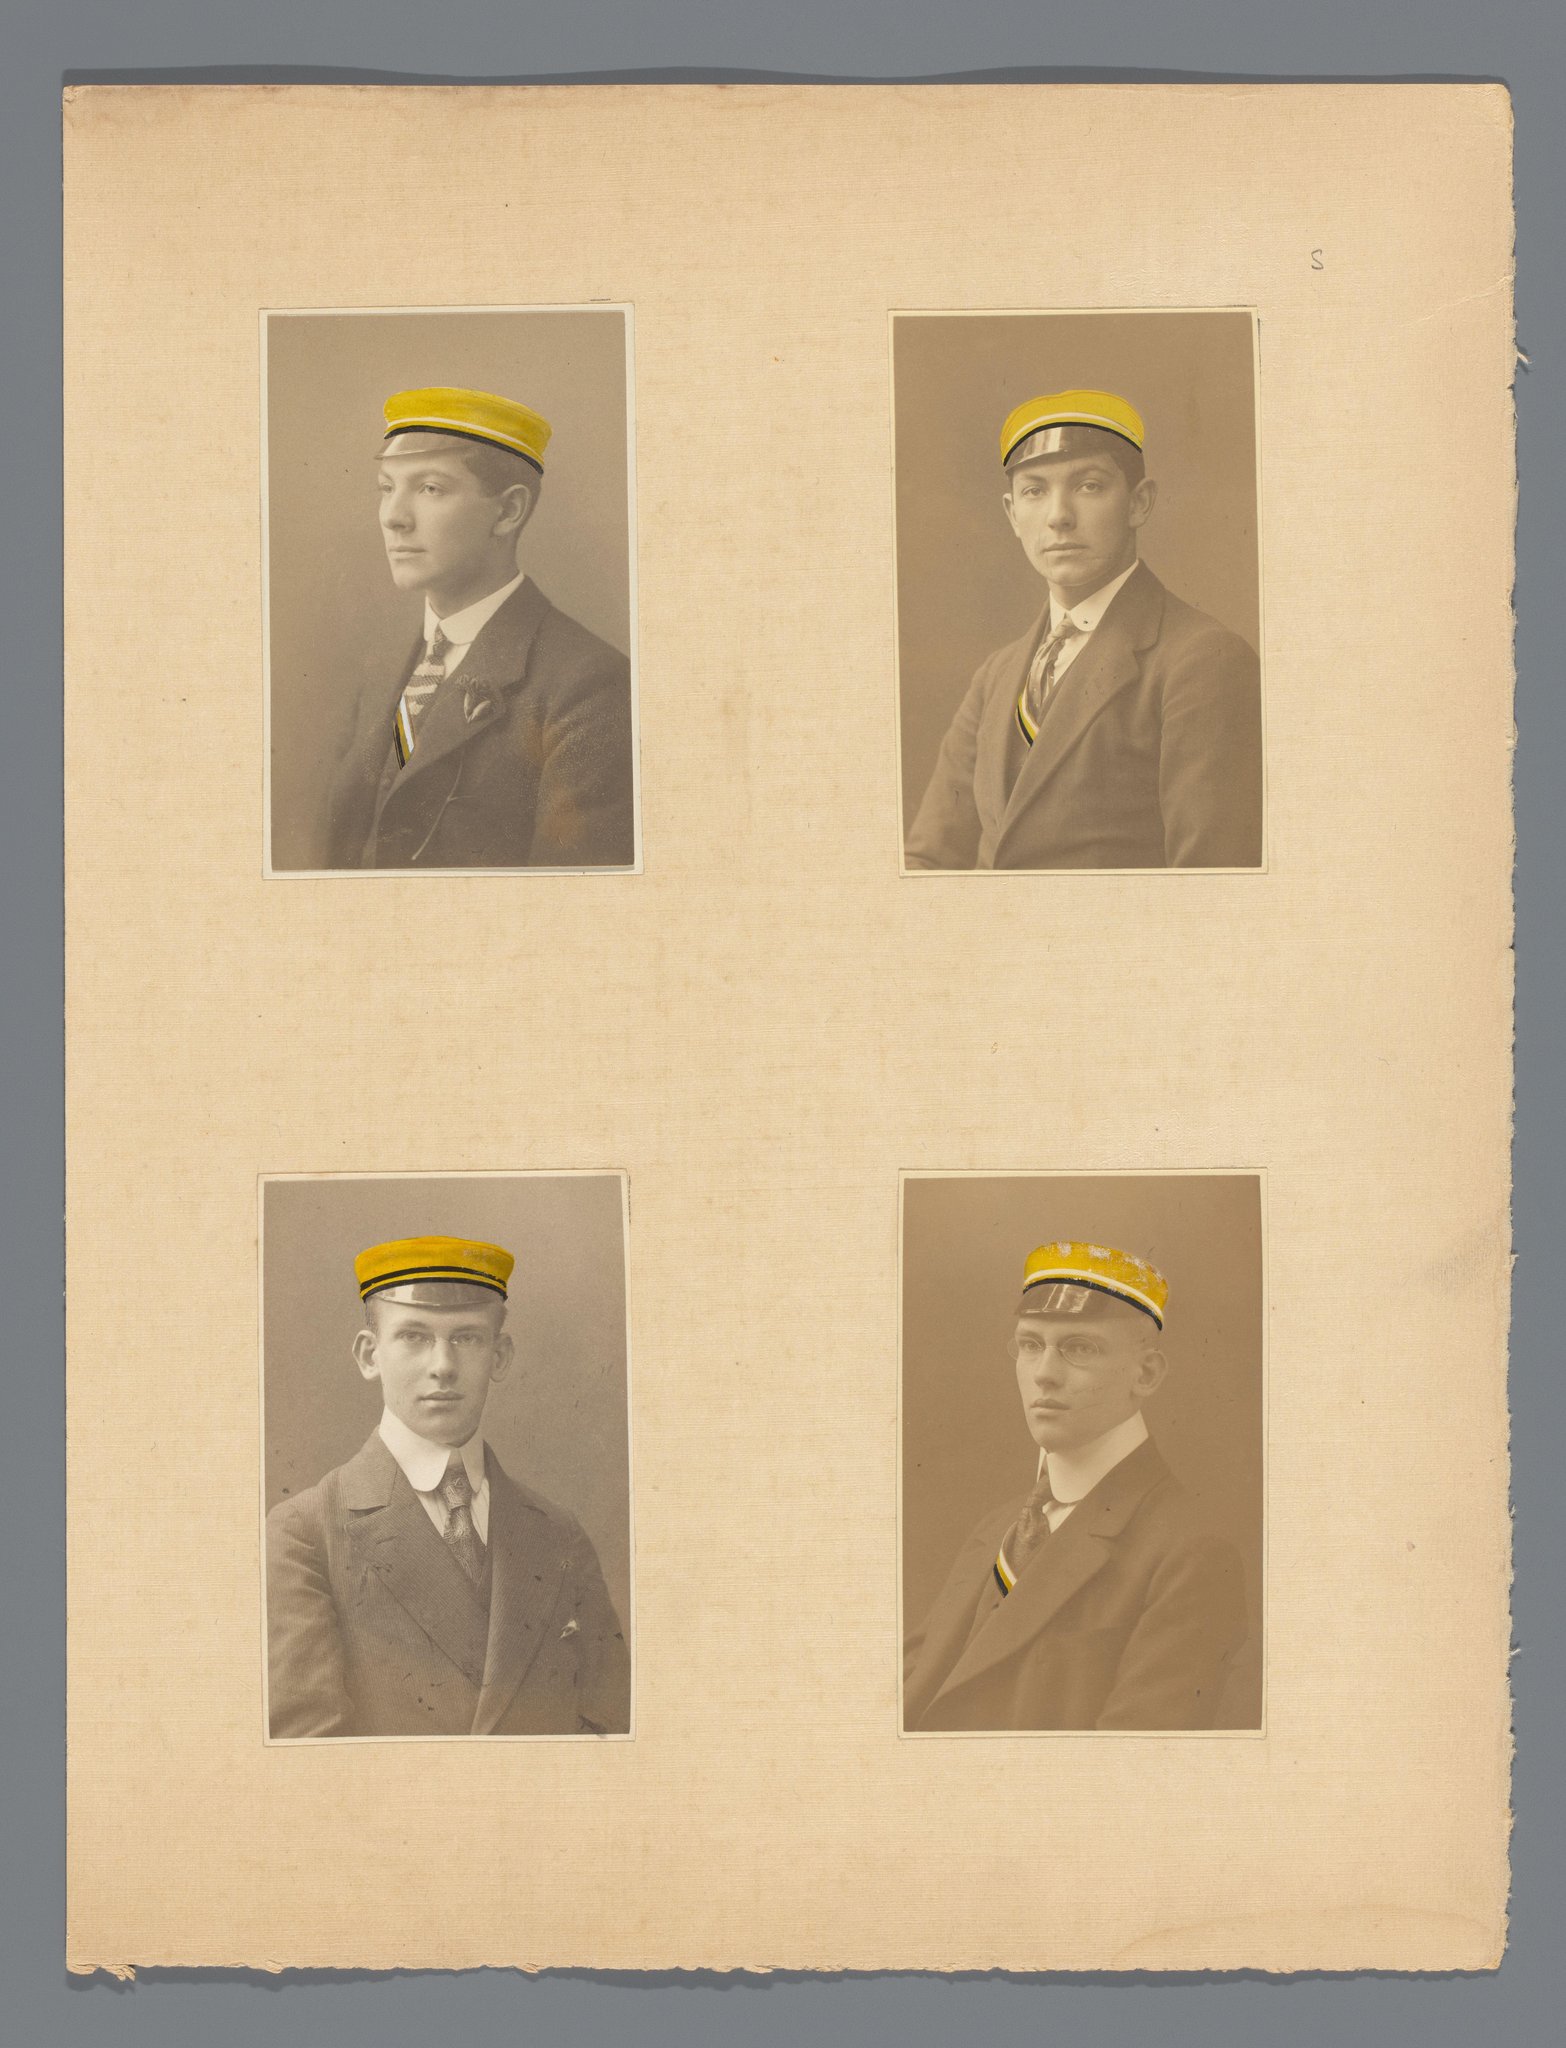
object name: blad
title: Blad met vier portretten van studenten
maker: Anonymous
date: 1890-1920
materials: cardboard, paint, photographic support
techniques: gelatin silver print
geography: germany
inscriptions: inscription: ‘Etudiants Heidelberg’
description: De petten en sjerpen zijn gekleurd met gele verf.